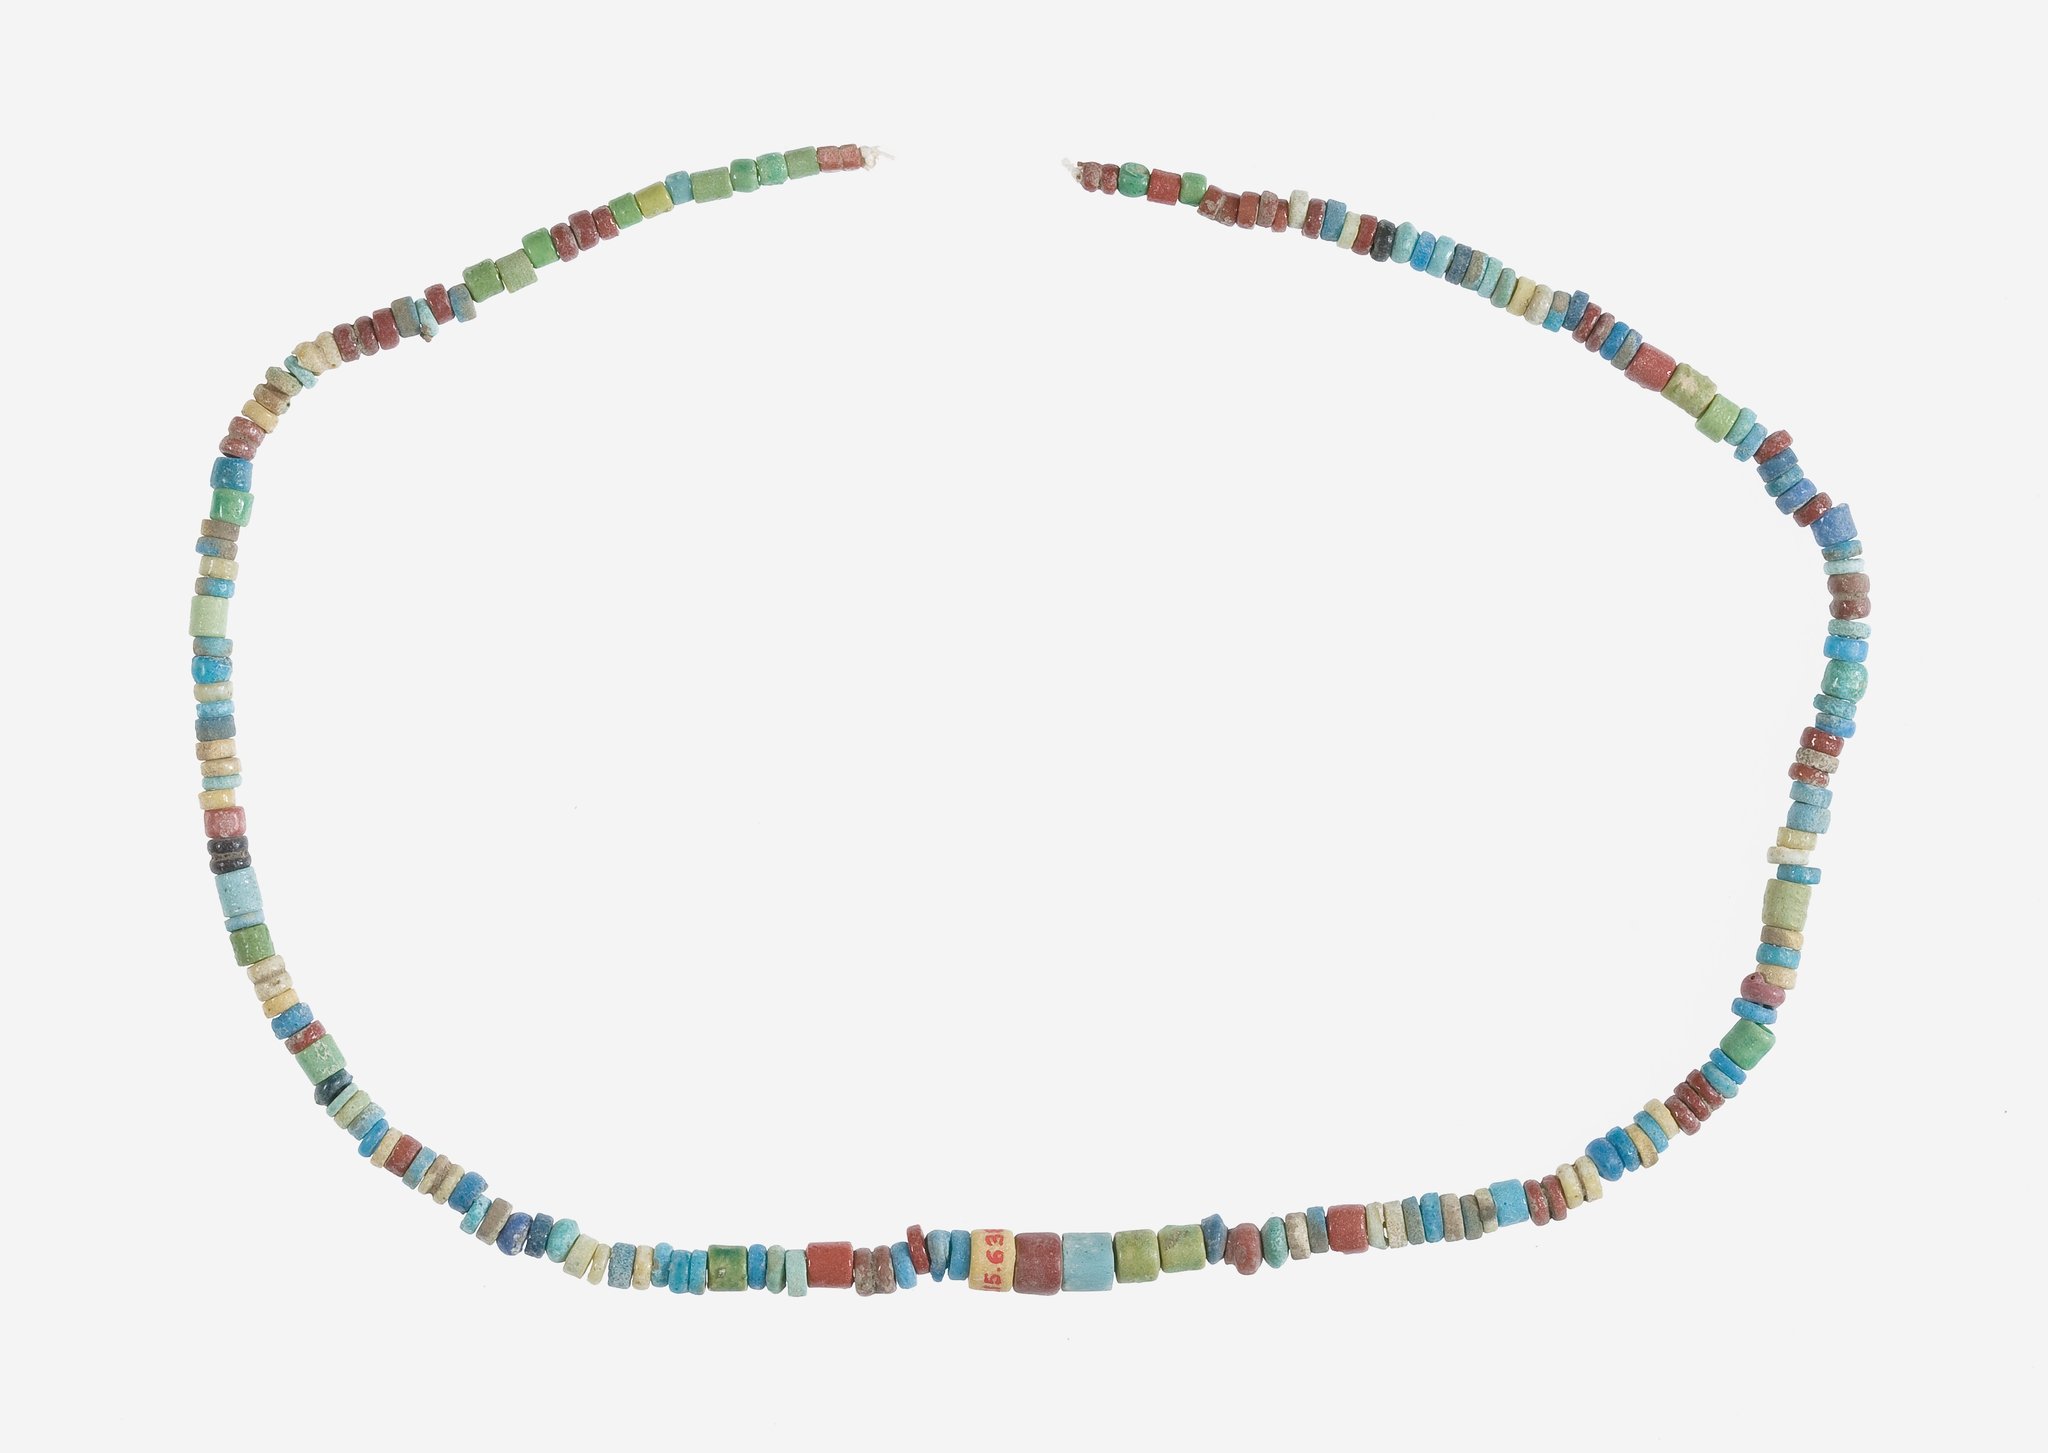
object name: bead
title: String of Beads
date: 1390-1352 BCE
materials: faience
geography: egypt